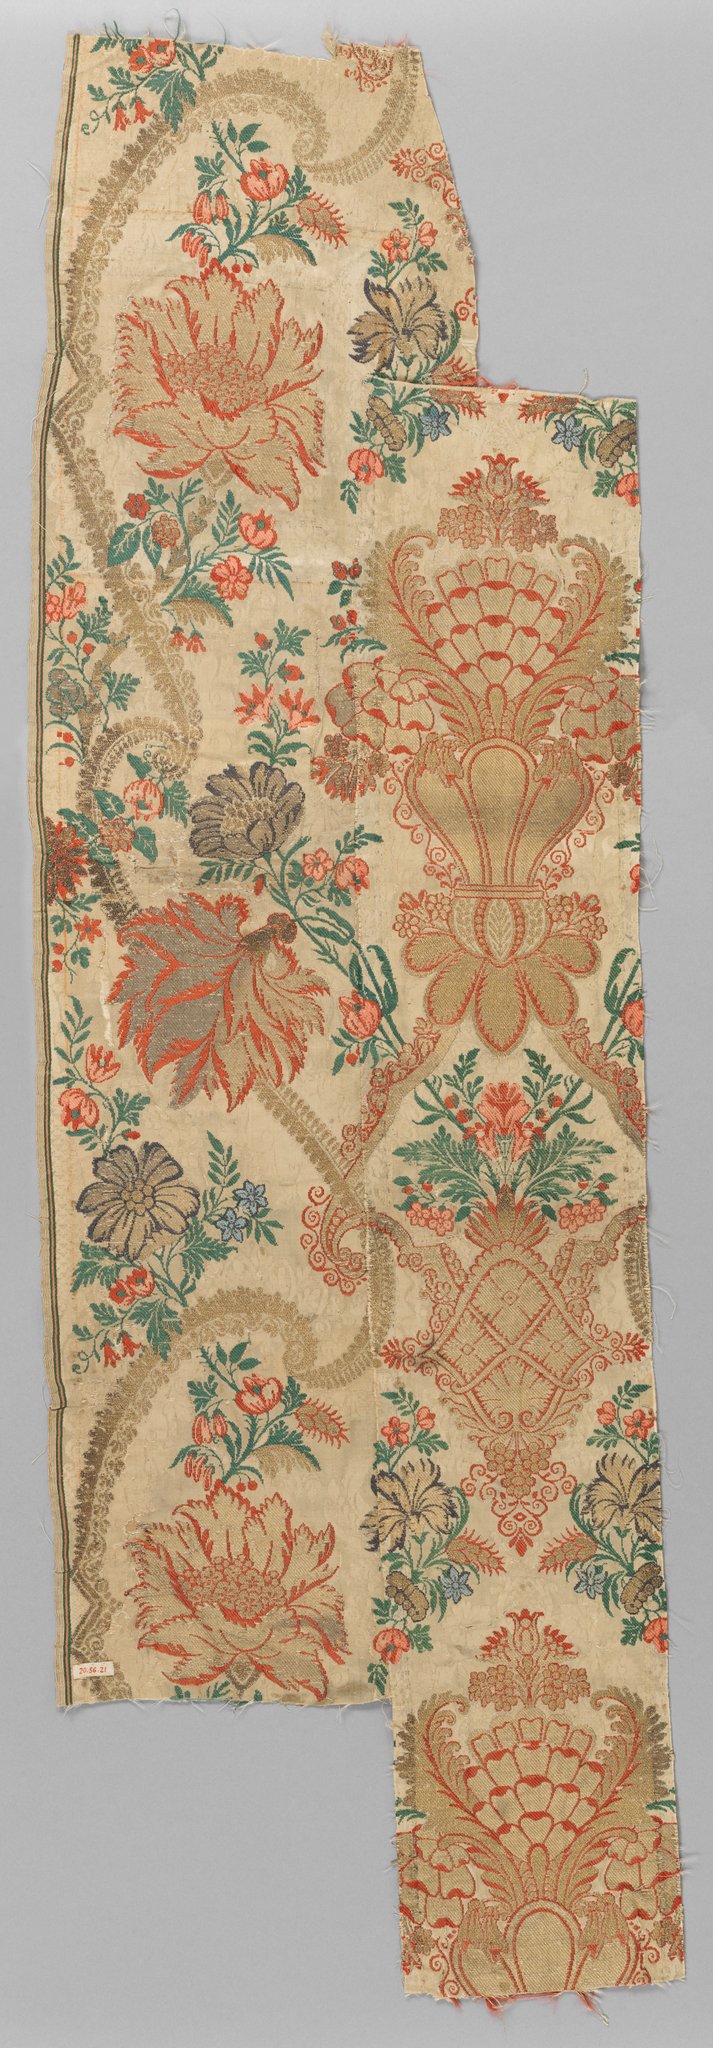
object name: piece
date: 1720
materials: metal thread, silk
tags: flowers,leaves